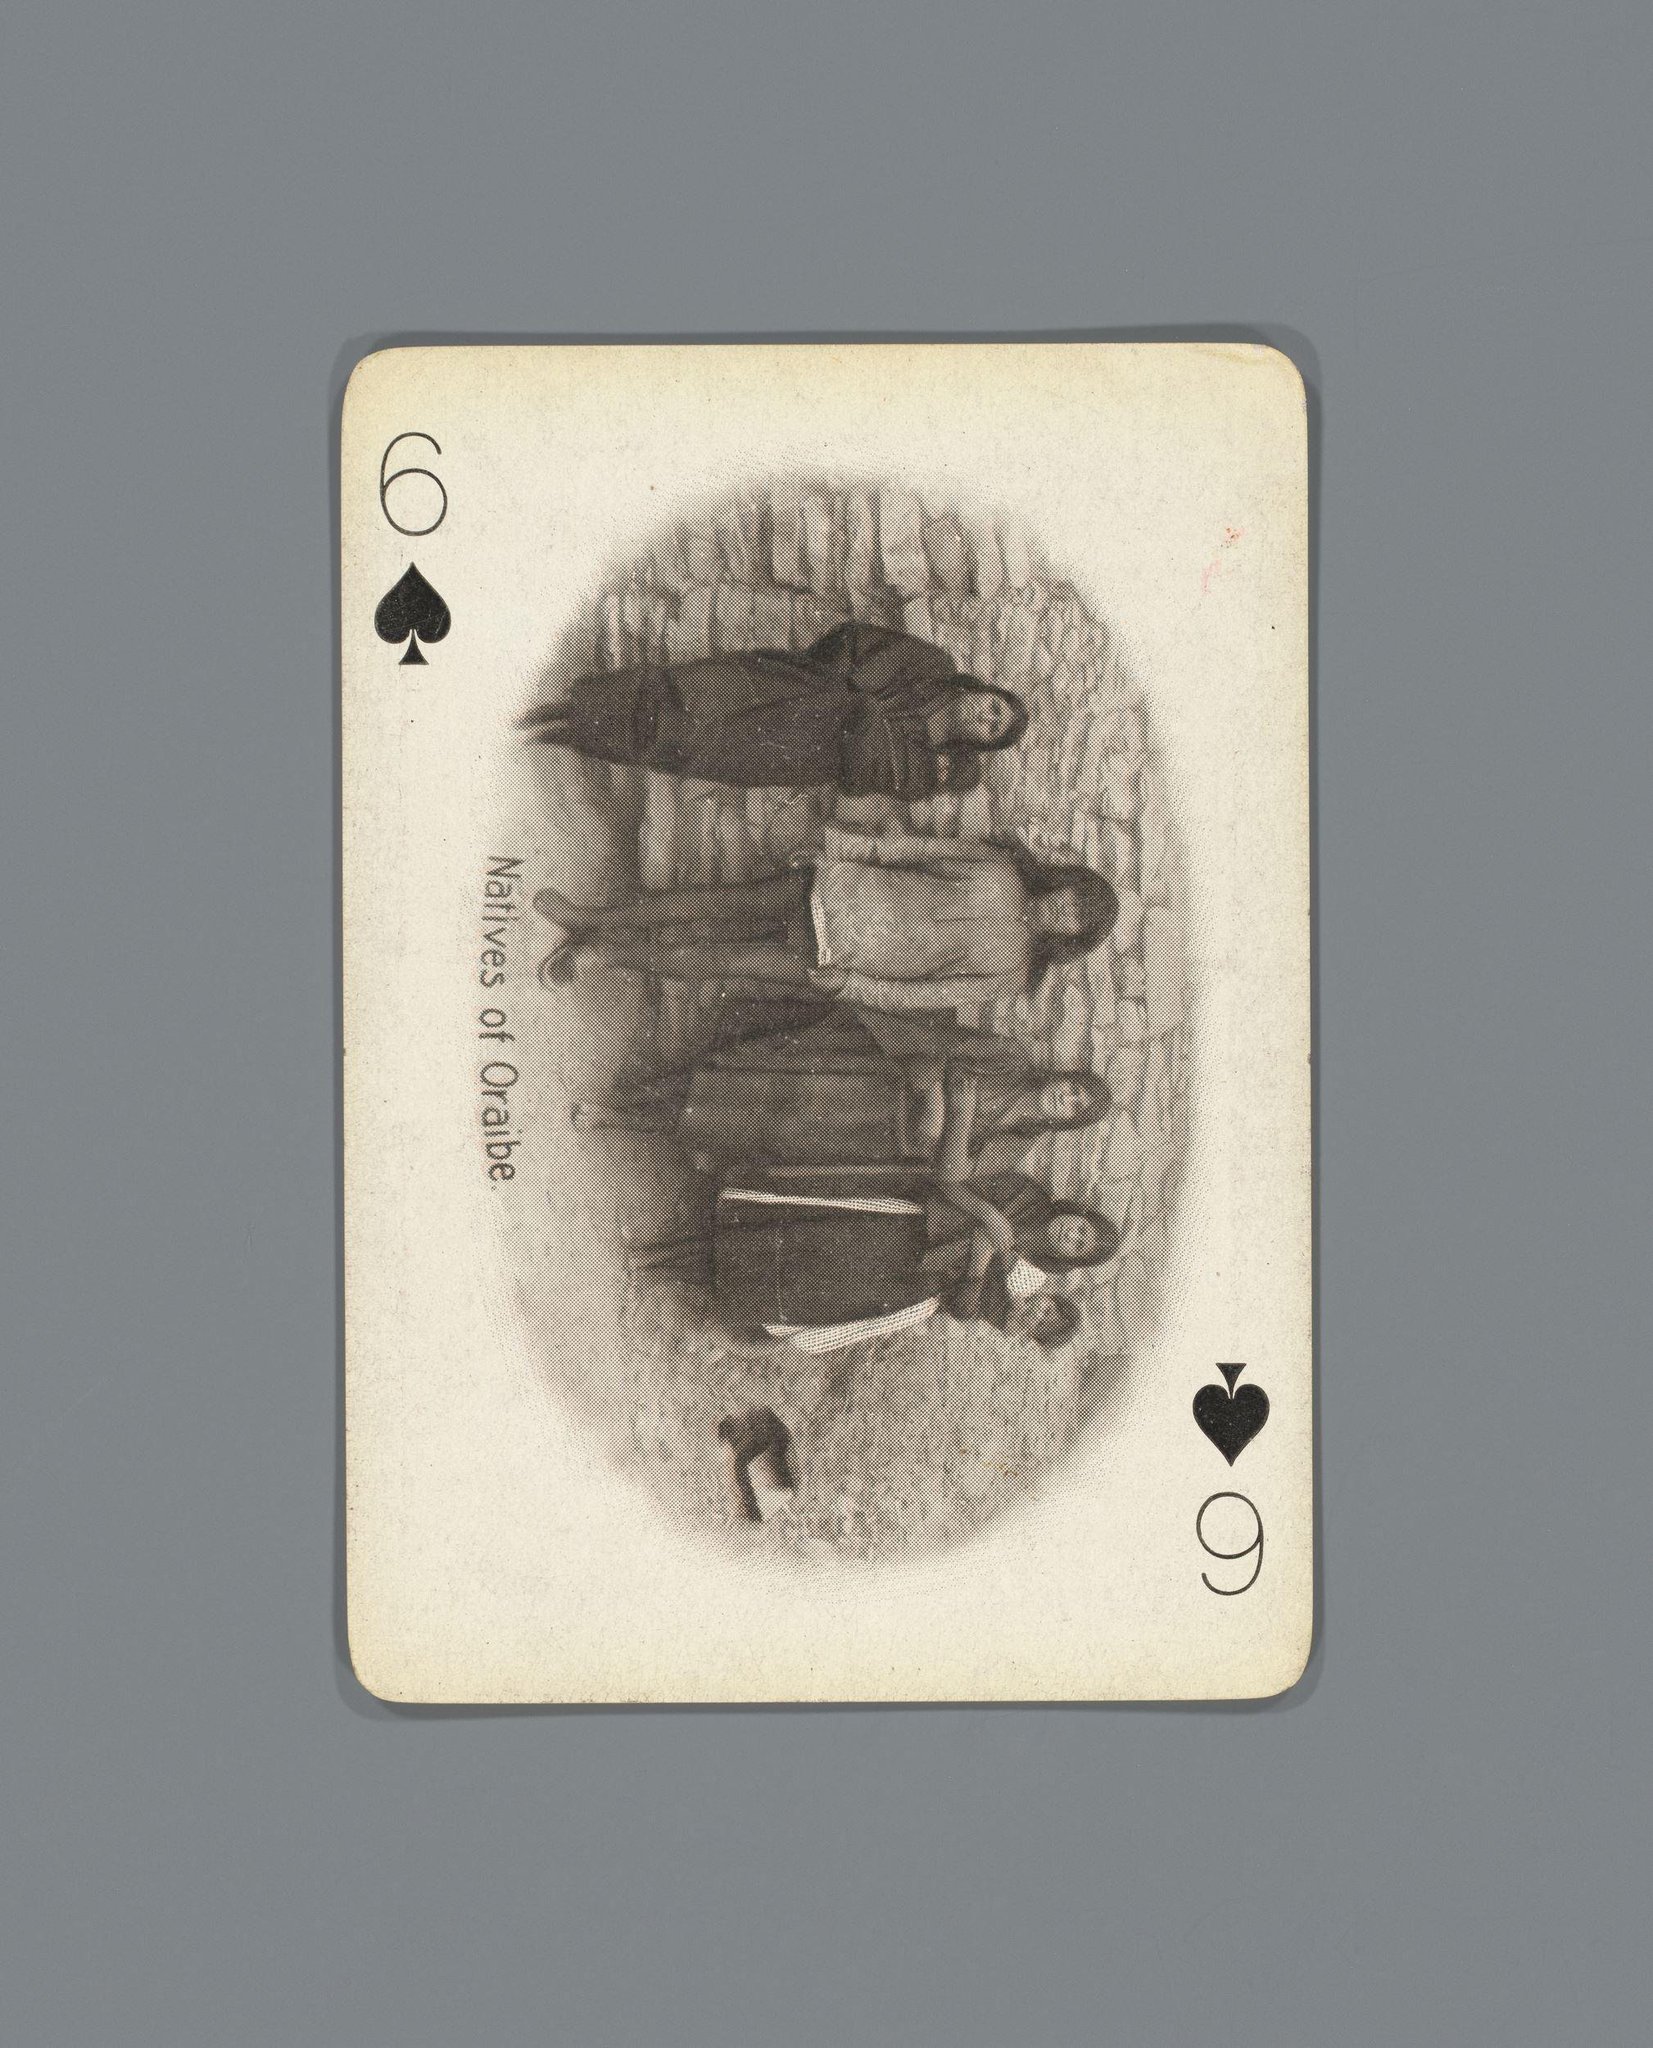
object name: photograph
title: Schoppen zes met inwoners van Oraibi, Navajo County, Arizona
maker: adam clark vroman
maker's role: fotograaf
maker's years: 1856-1916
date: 1900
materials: paper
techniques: autotype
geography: los angeles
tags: arizona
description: Speelkaart uit doosje met 53 speelkaarten met afbeeldingen in autotypie van Native Americans. De inhoud bevat een complete set speelkaarten inclusief joker.